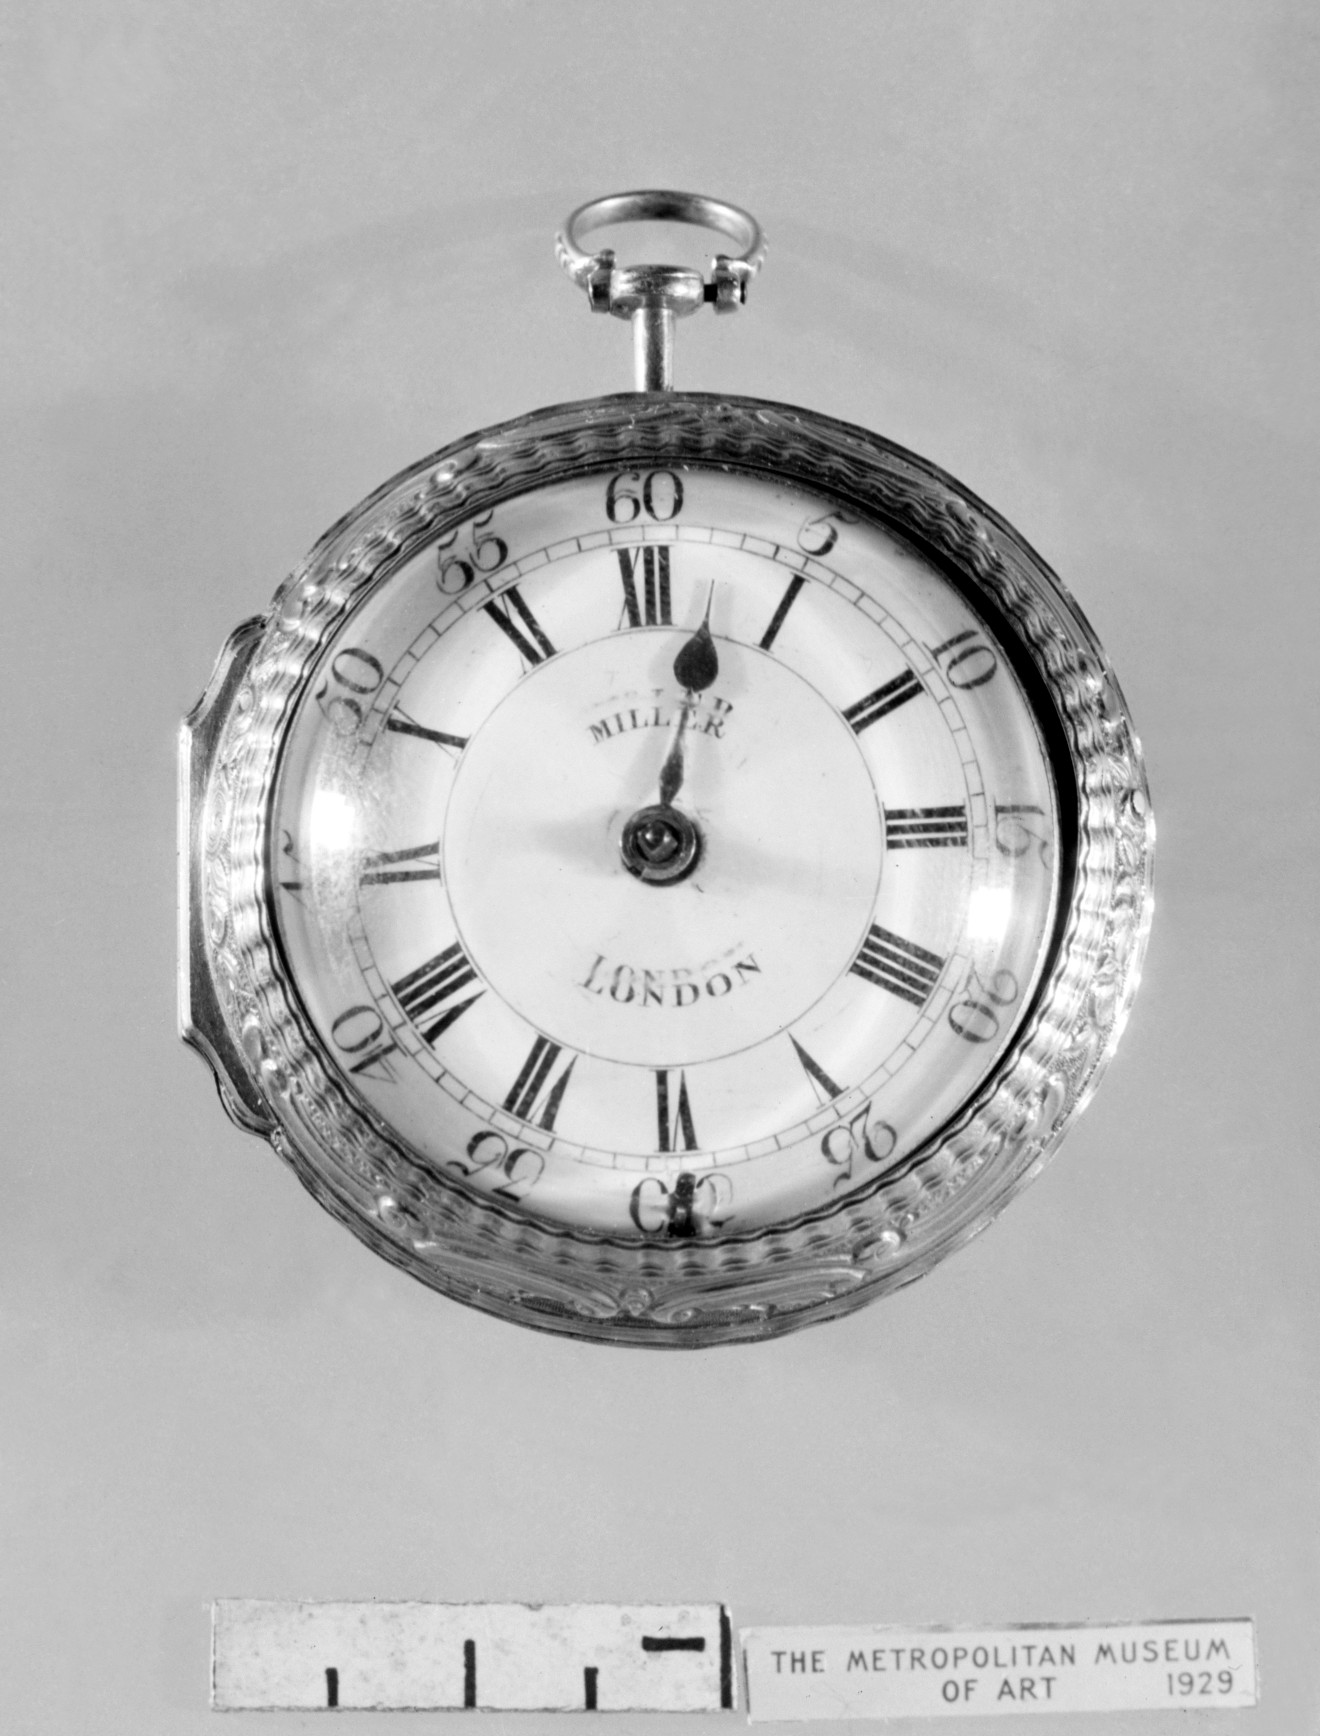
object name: watch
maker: thomas miller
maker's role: maker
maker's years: 1764-1780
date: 1701-1800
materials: gold